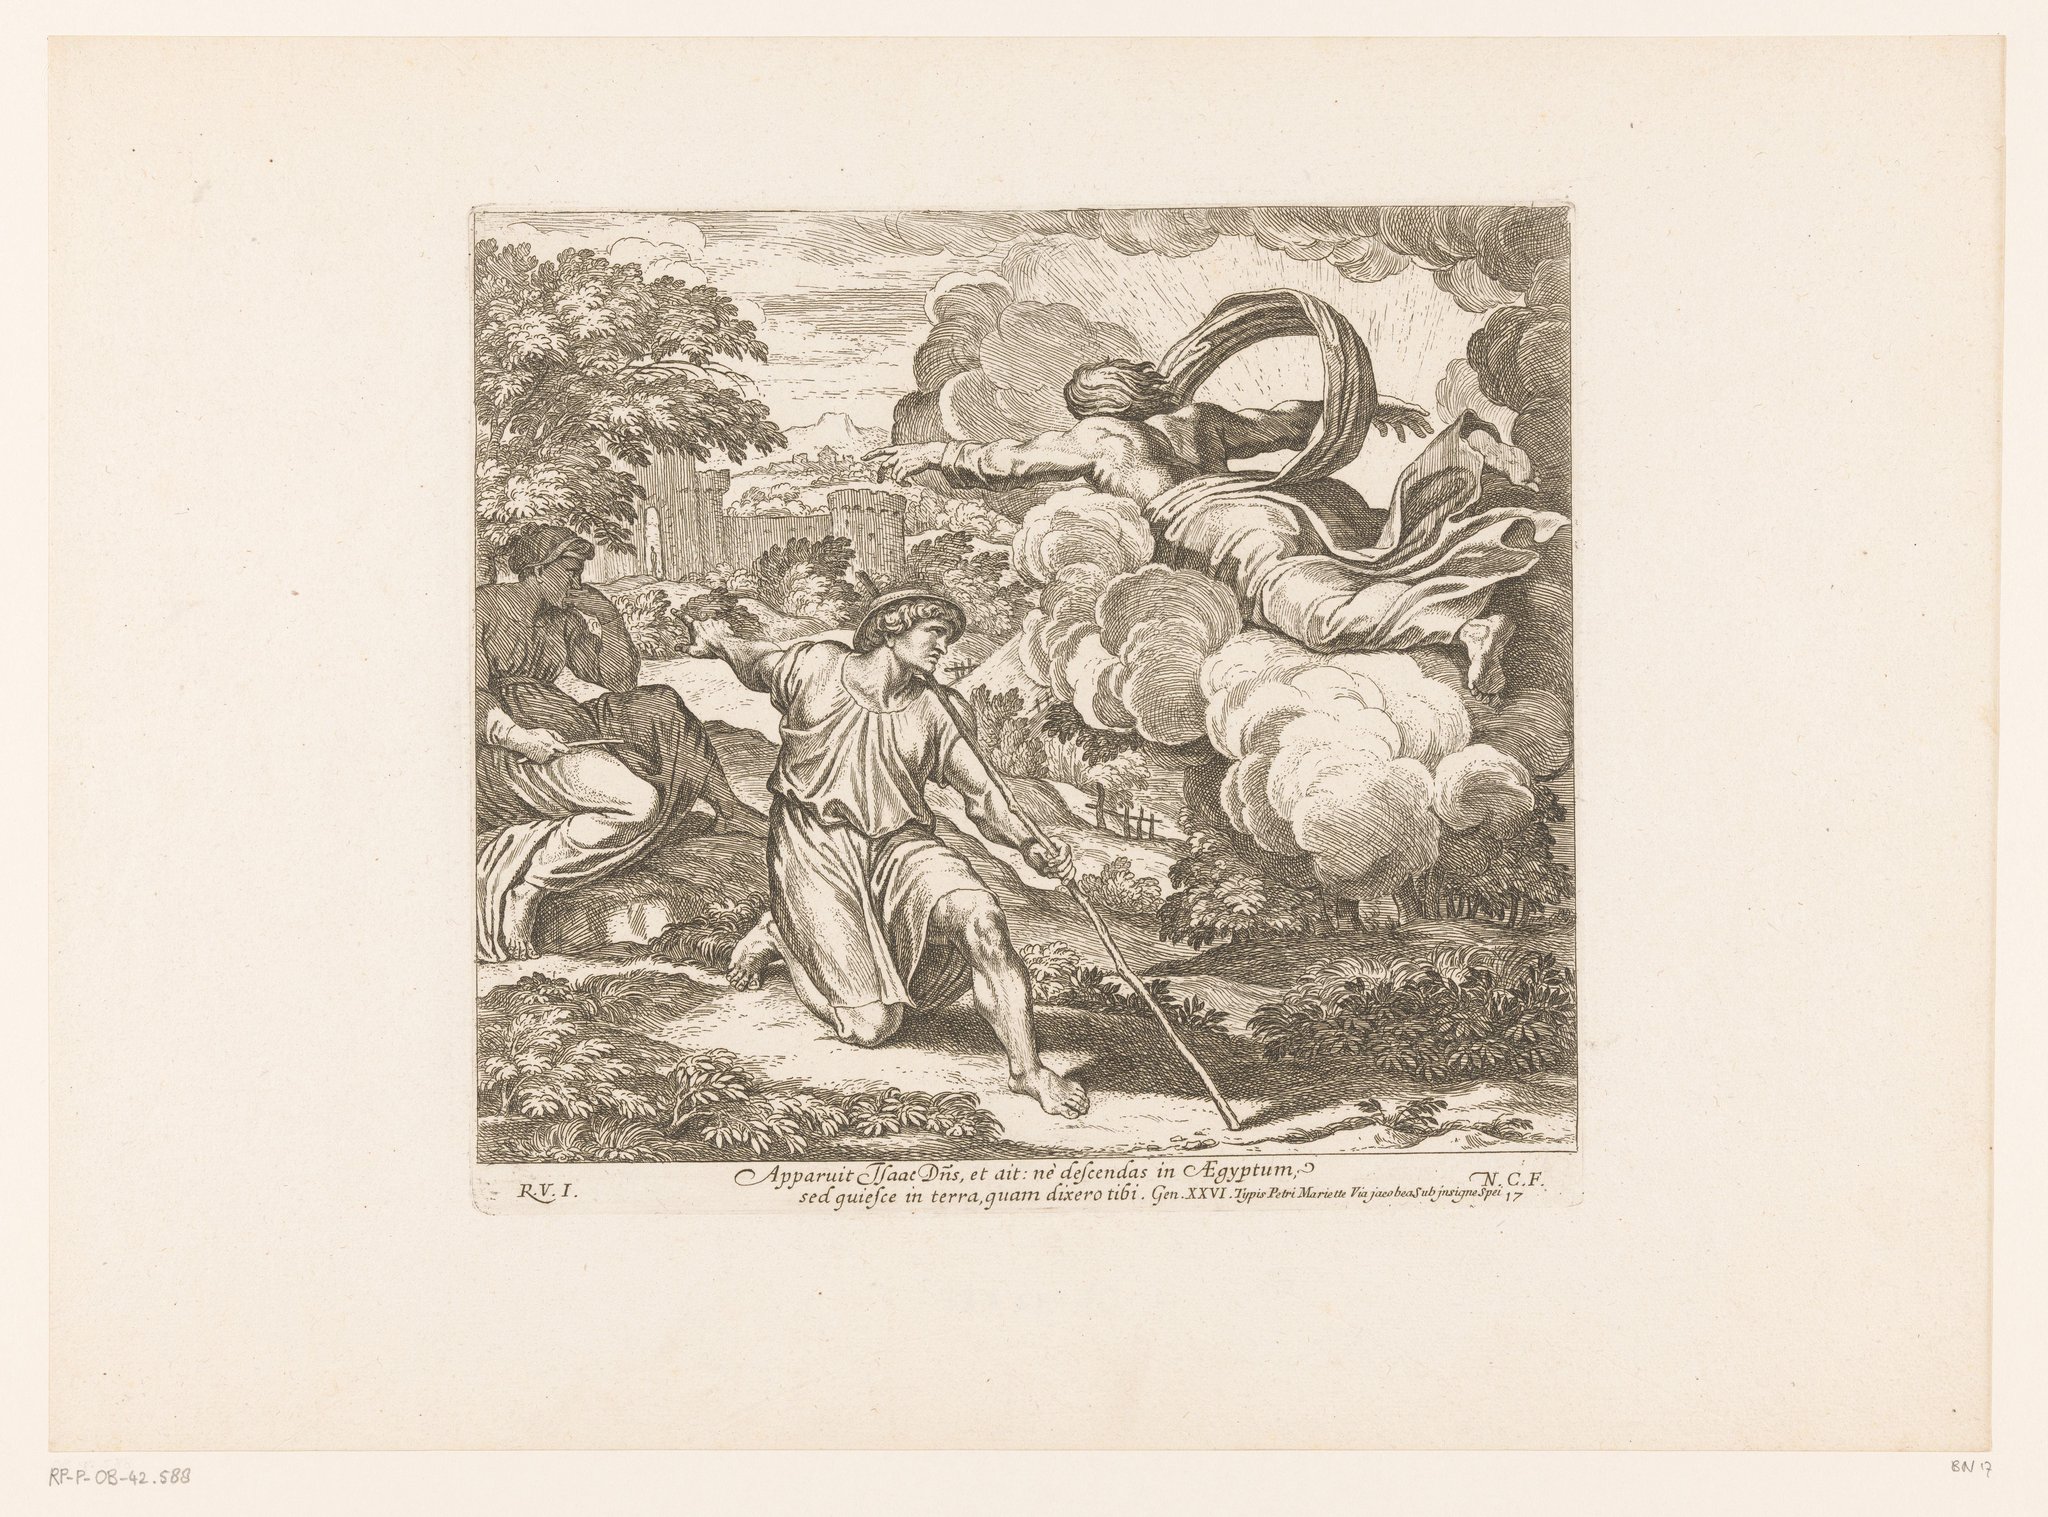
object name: print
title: Sacrae Historiae Acta a Raphael Urbin in Vaticanis xystis ad picturae miraculum expressa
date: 1649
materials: paper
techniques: etching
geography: paris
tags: god appears to isaac and warns him not to journey into egypt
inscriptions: collector's mark: Lugt 2228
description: Prent uit de Sacrae Historiae Acta a Raphael Urbin in Vaticanis xystis ad picturae miraculum expressa, ook bekend als de Rafaël Bijbel. De serie bestaat uit 54 platen, waarvan twee titelprenten, de eerste met een opdracht aan Rafaël, de tweede met een opdracht aan Renard. De overige 52 platen betreffen composities naar schilderingen in de Loggia van Rafaël in het Vaticaan. De serie werd in 1649 uitgegeven door Pierre Mariette te Parijs.